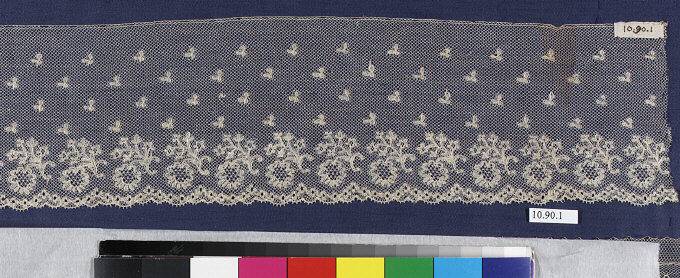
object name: piece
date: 1801-1900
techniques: lace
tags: flowers,leaves